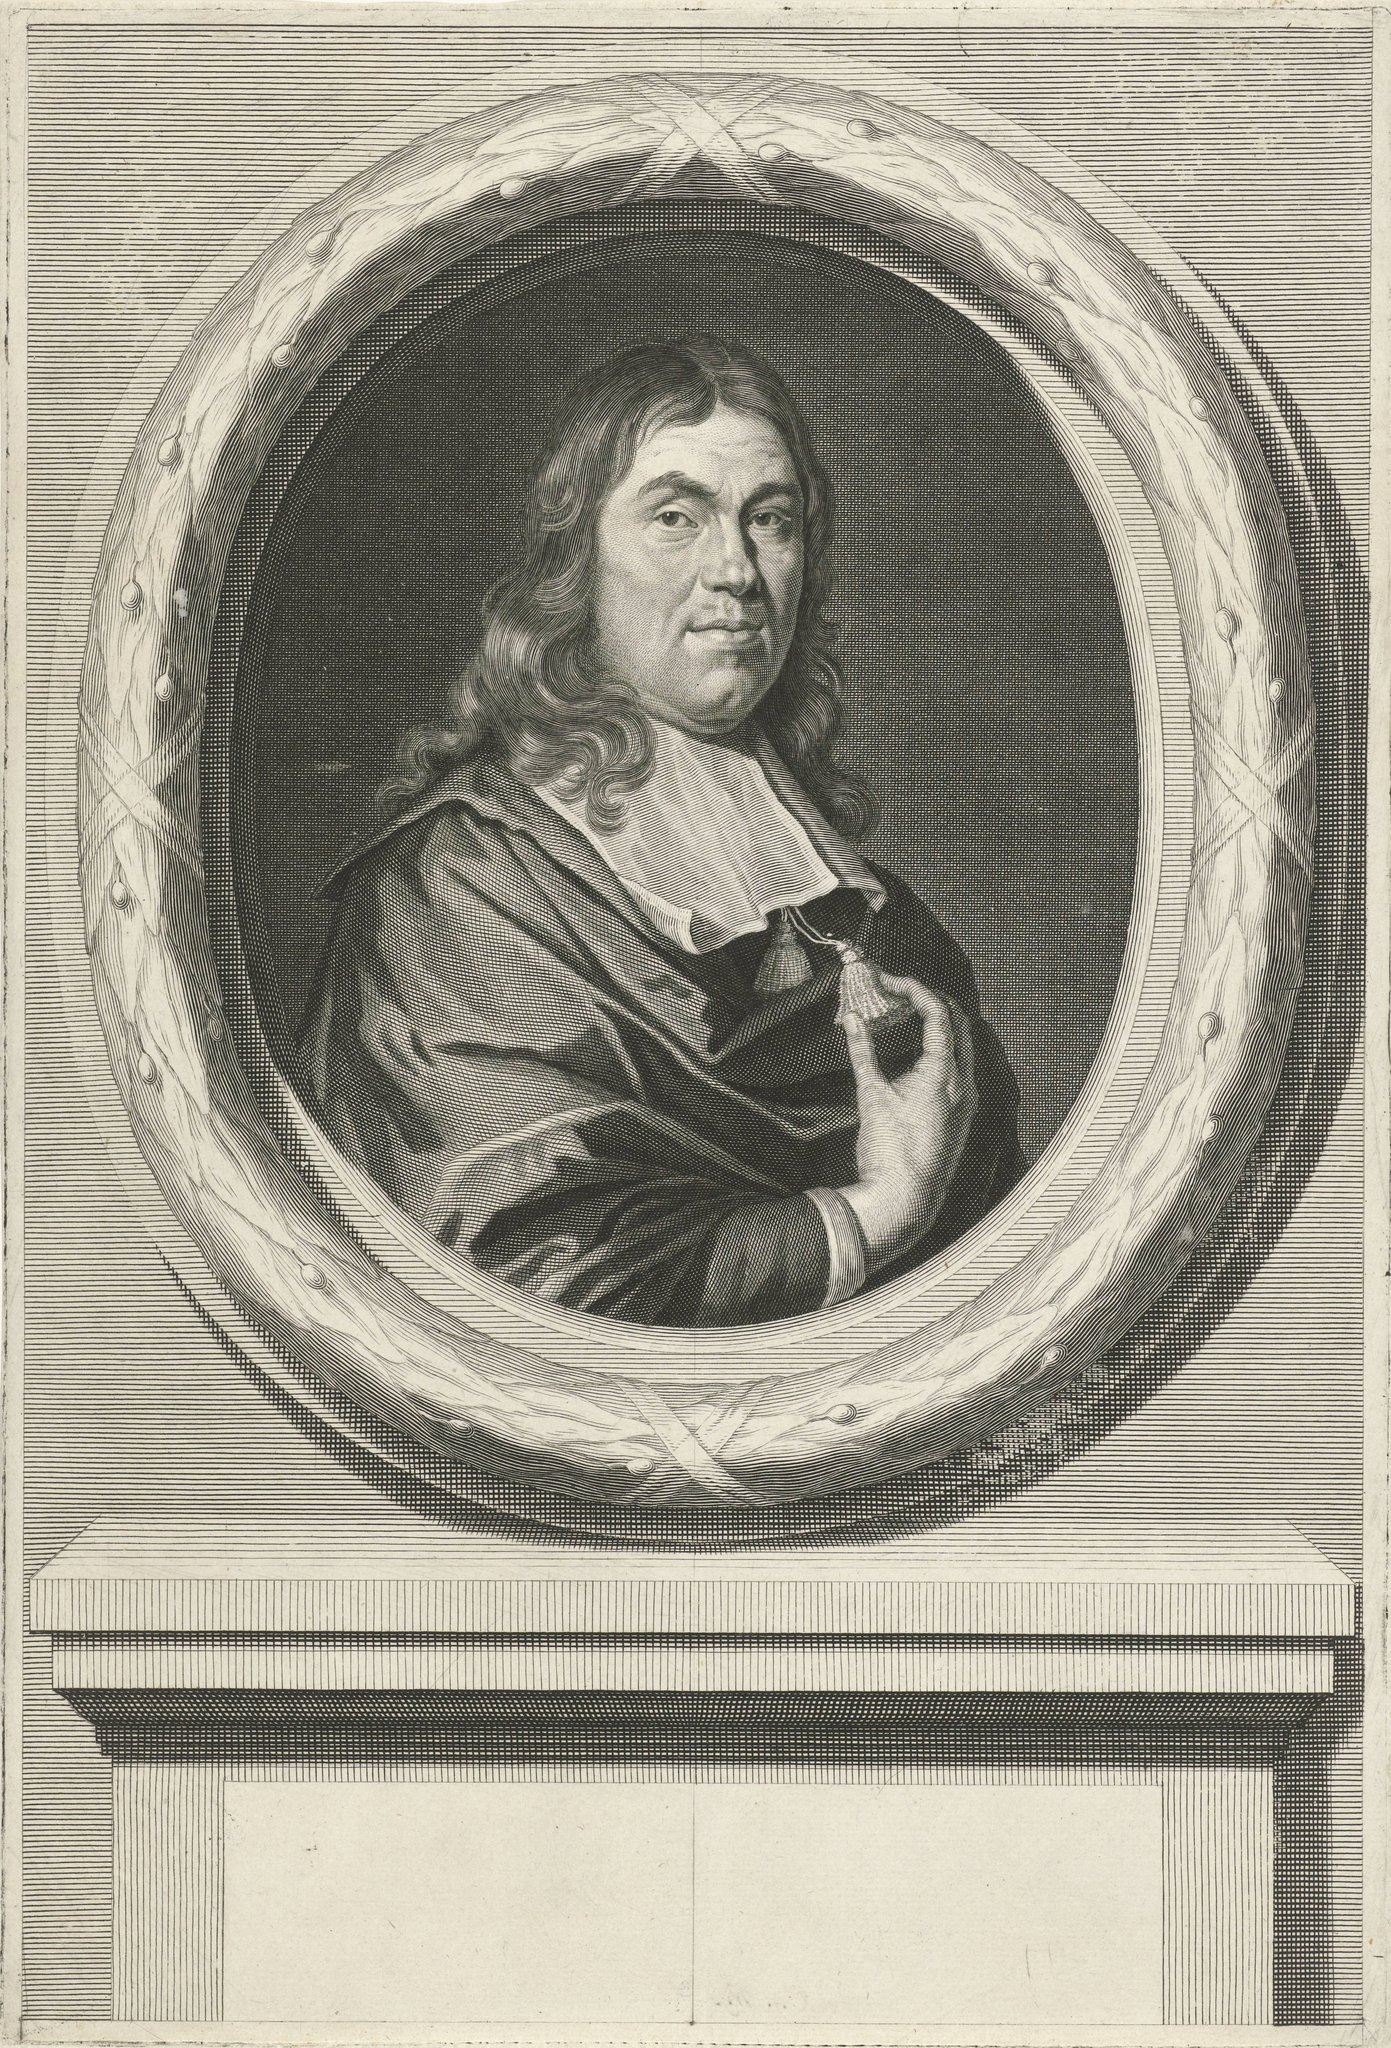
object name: print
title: Portret van Jan de Wys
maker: jan van munnickhuysen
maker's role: draughtsman, print maker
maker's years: 1655-1701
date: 1664-1721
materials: paper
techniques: engraving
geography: netherlands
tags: koopman, jan de wys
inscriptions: collector's mark: Lugt 2228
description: Portret van Jan de Wys, makelaar in verfstoffen te Amsterdam.